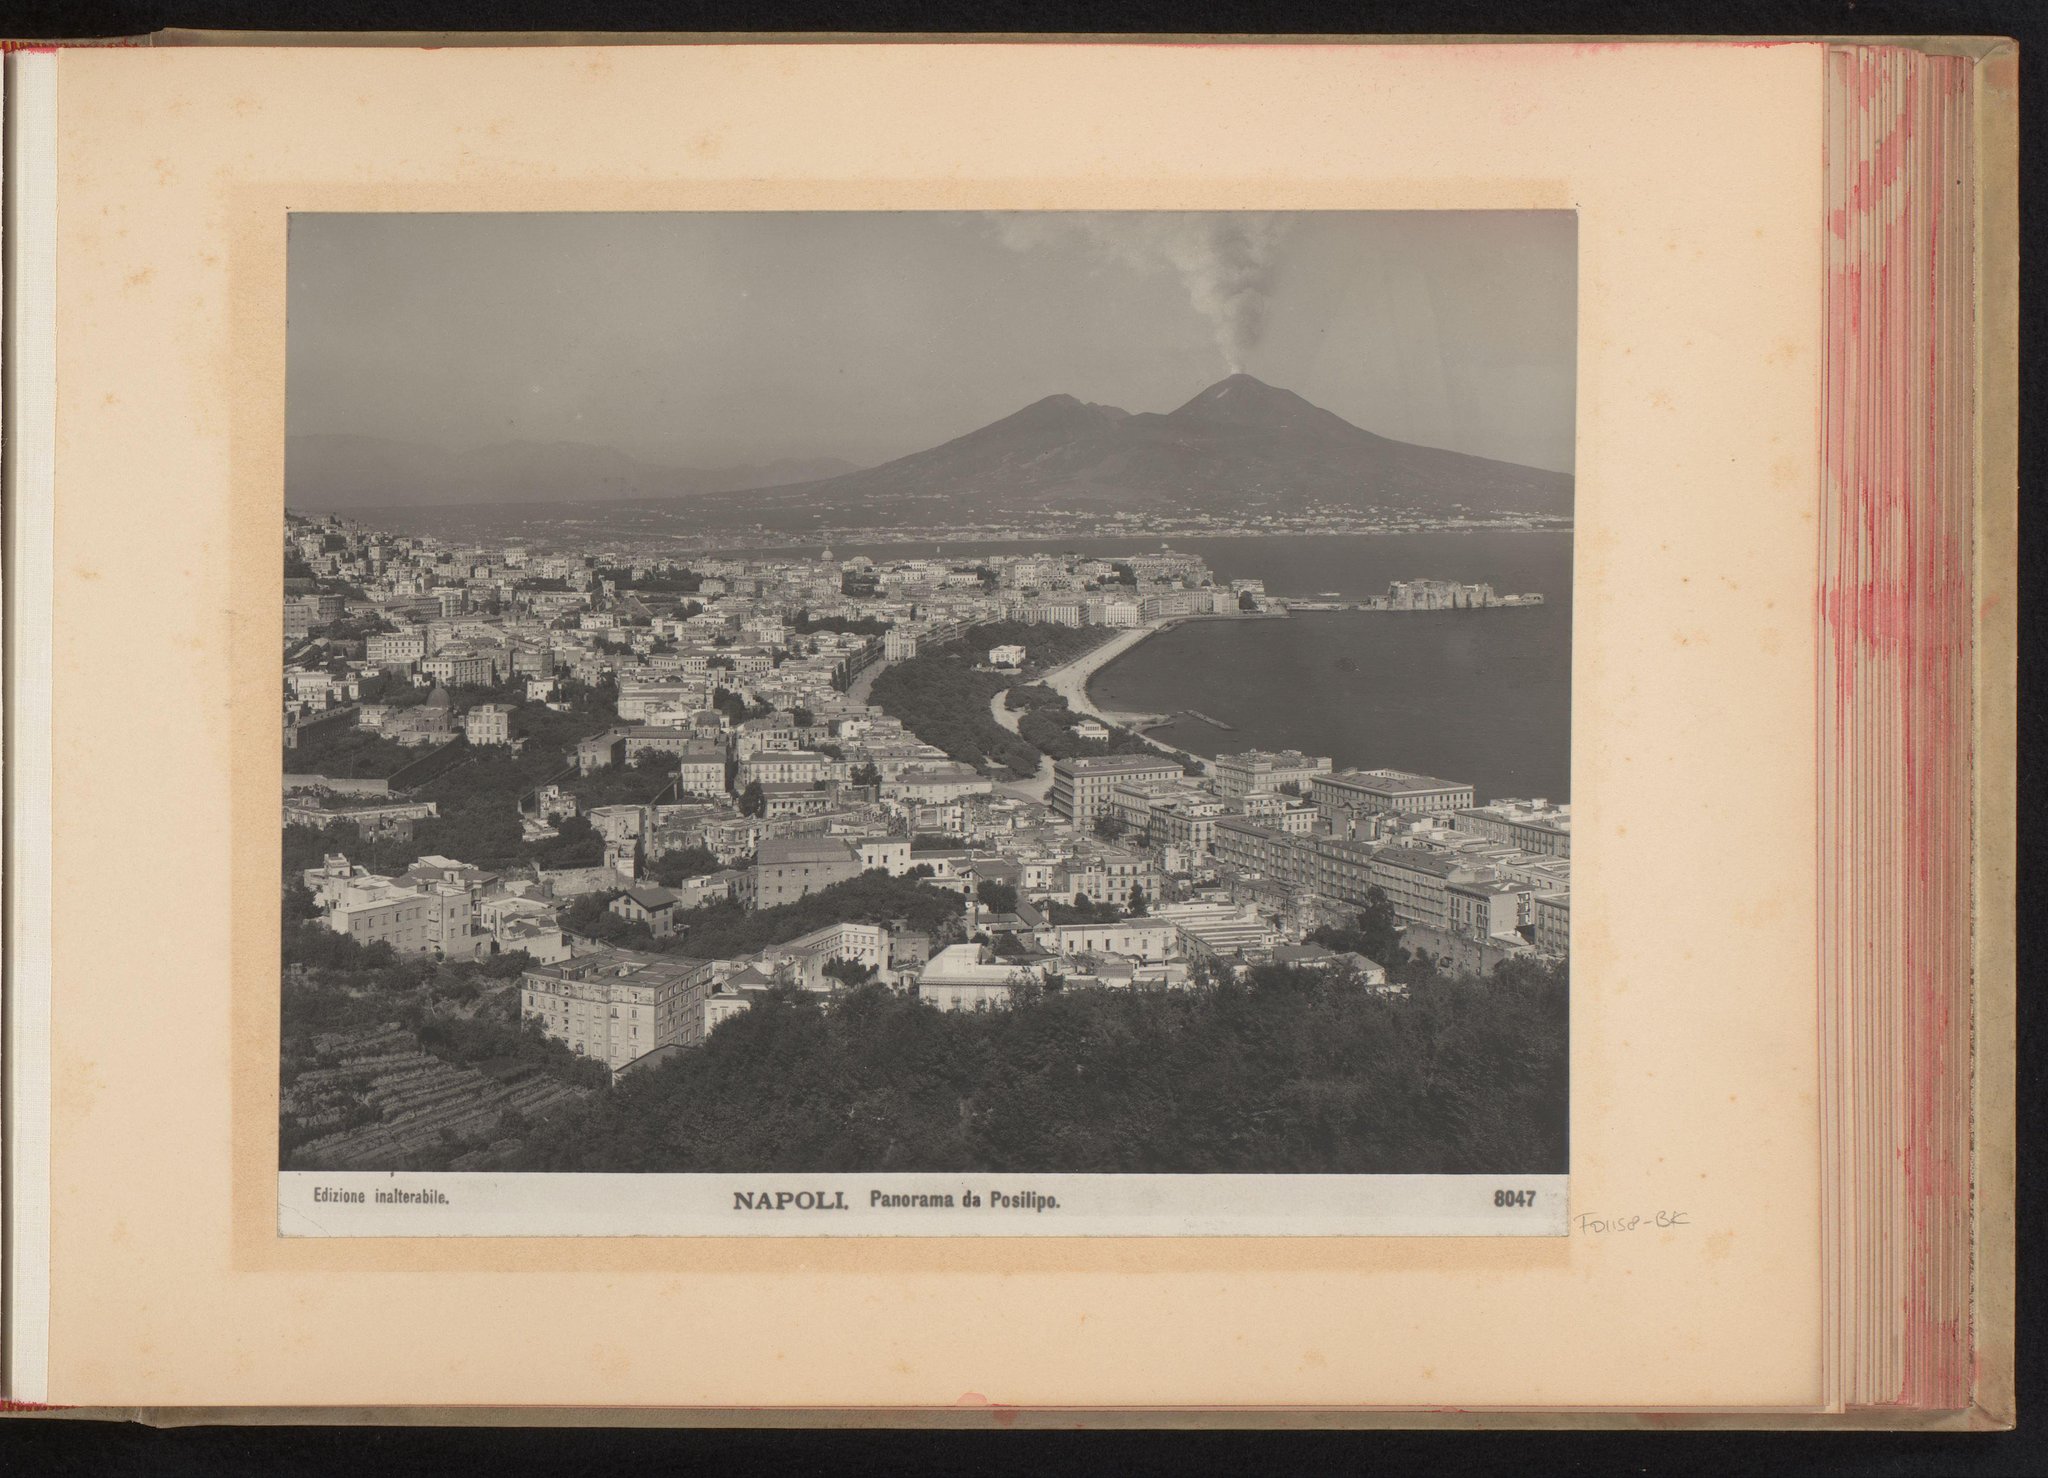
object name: photograph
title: Napoli. Panorama da Posilipo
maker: Anonymous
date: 1875-1907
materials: photographic support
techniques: gelatin silver print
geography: posillipo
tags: city-view in general; 'veduta', volcano, naples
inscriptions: number: ‘8047’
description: Onderdeel van Fotoalbum met opnames van bezienswaardigheden en kunstwerken in Italië.